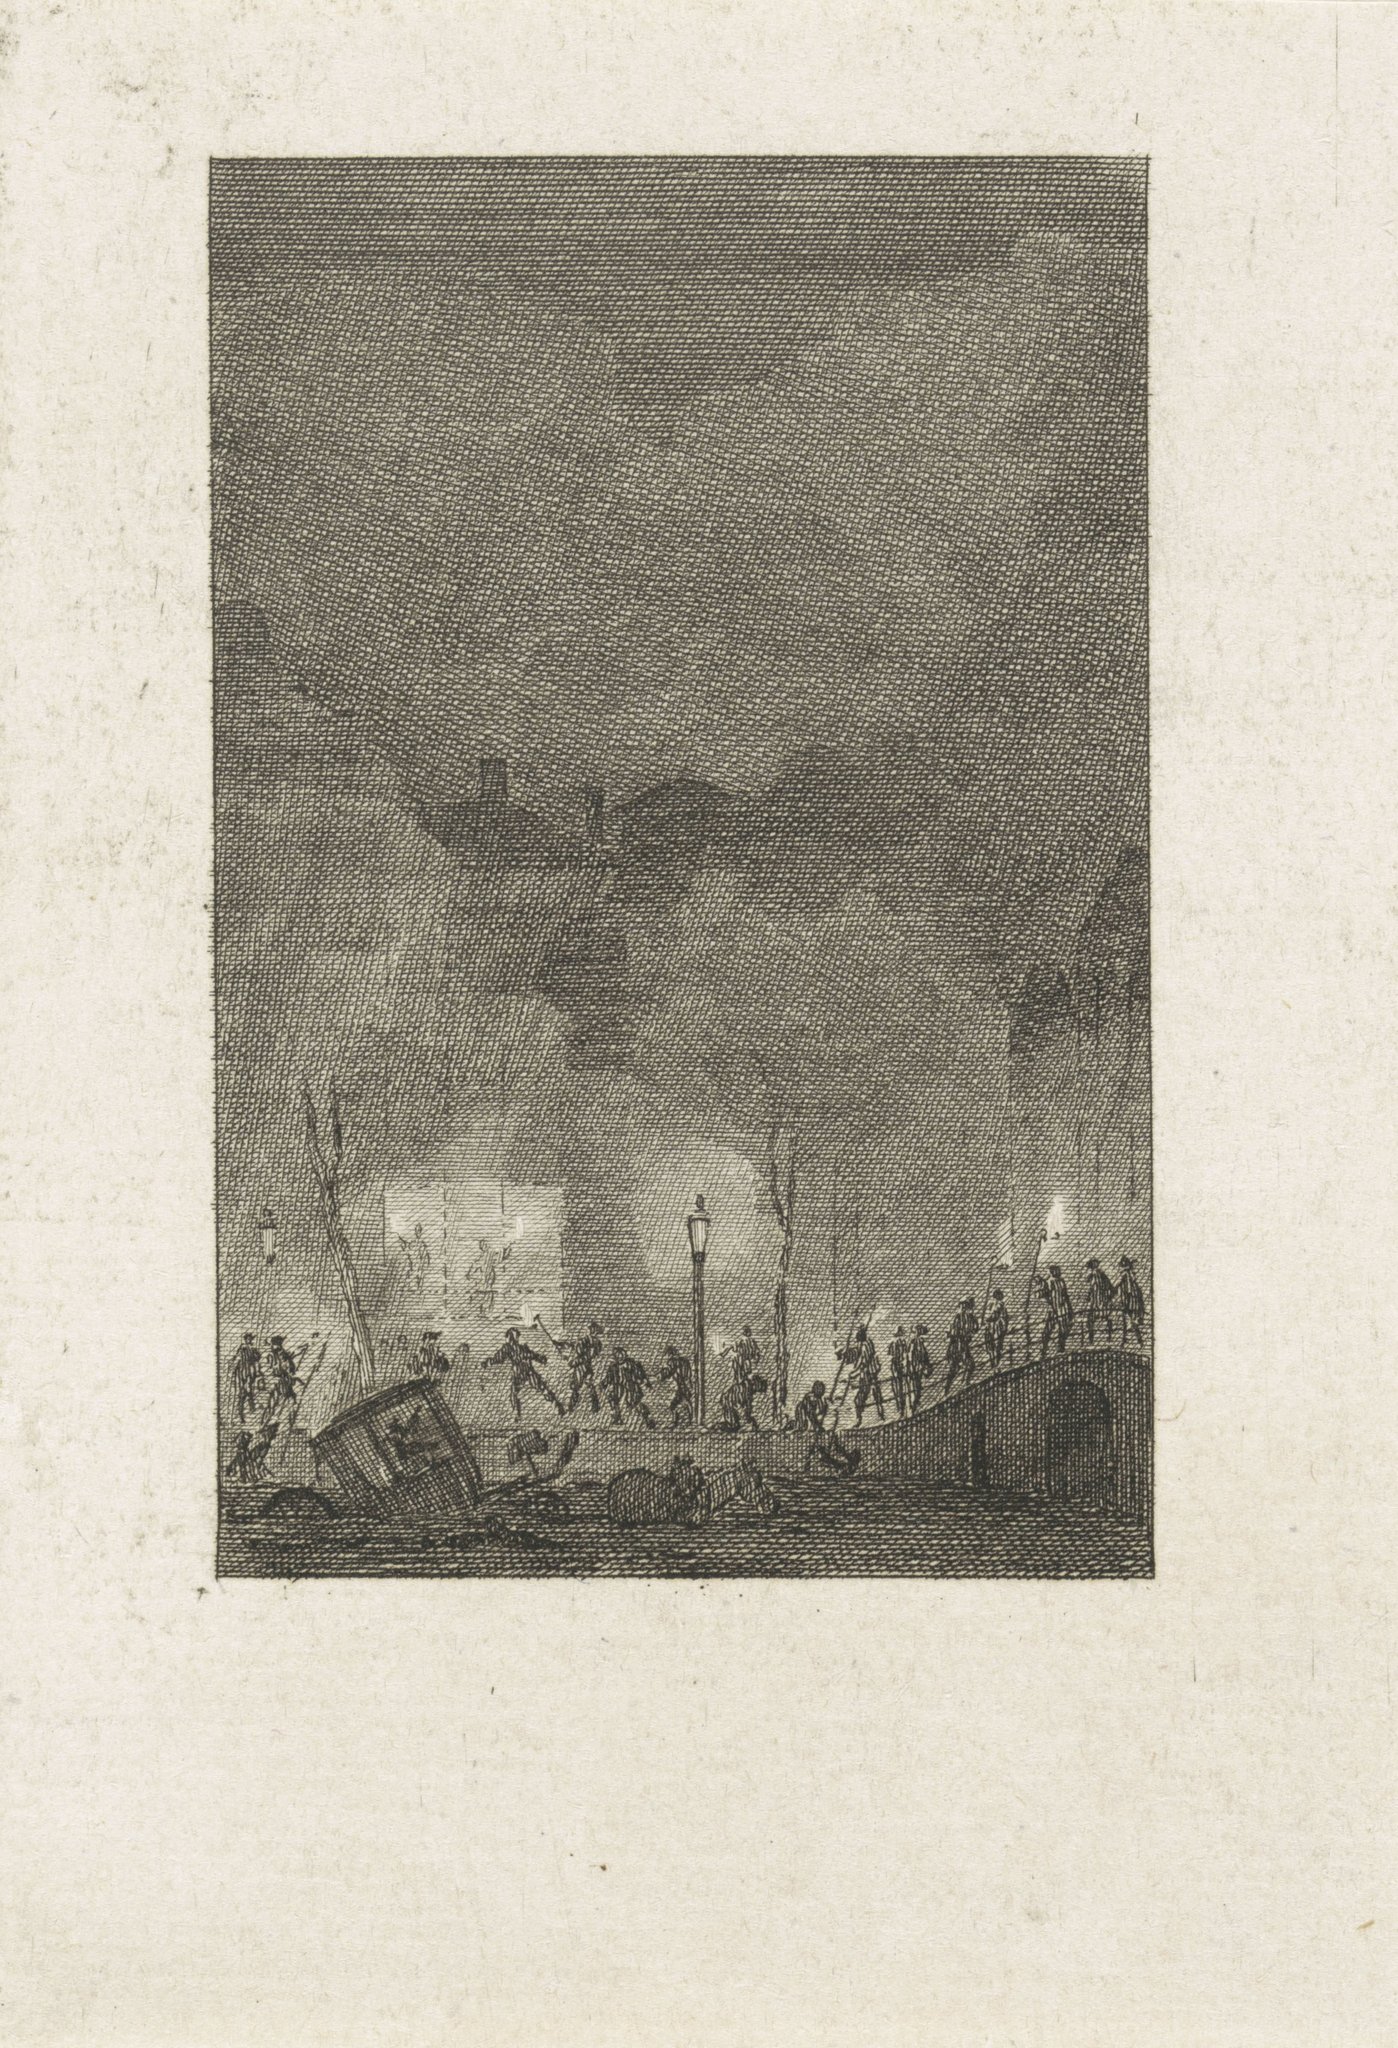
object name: print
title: Zware mist te Amsterdam, 1790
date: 1791-1795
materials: paper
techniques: engraving, etching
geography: northern netherlands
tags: mist, fog, amsterdam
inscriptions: collector's mark: Lugt 2228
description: Gebruikt als illustratie in: J. Fokke, Geschiedenissen der Vereenigde Nederlanden voor de vaderlandsche jeugd, Johannes Allart, Amsterdam 1783-1795, 25 delen, dl. 23, pl. 5.